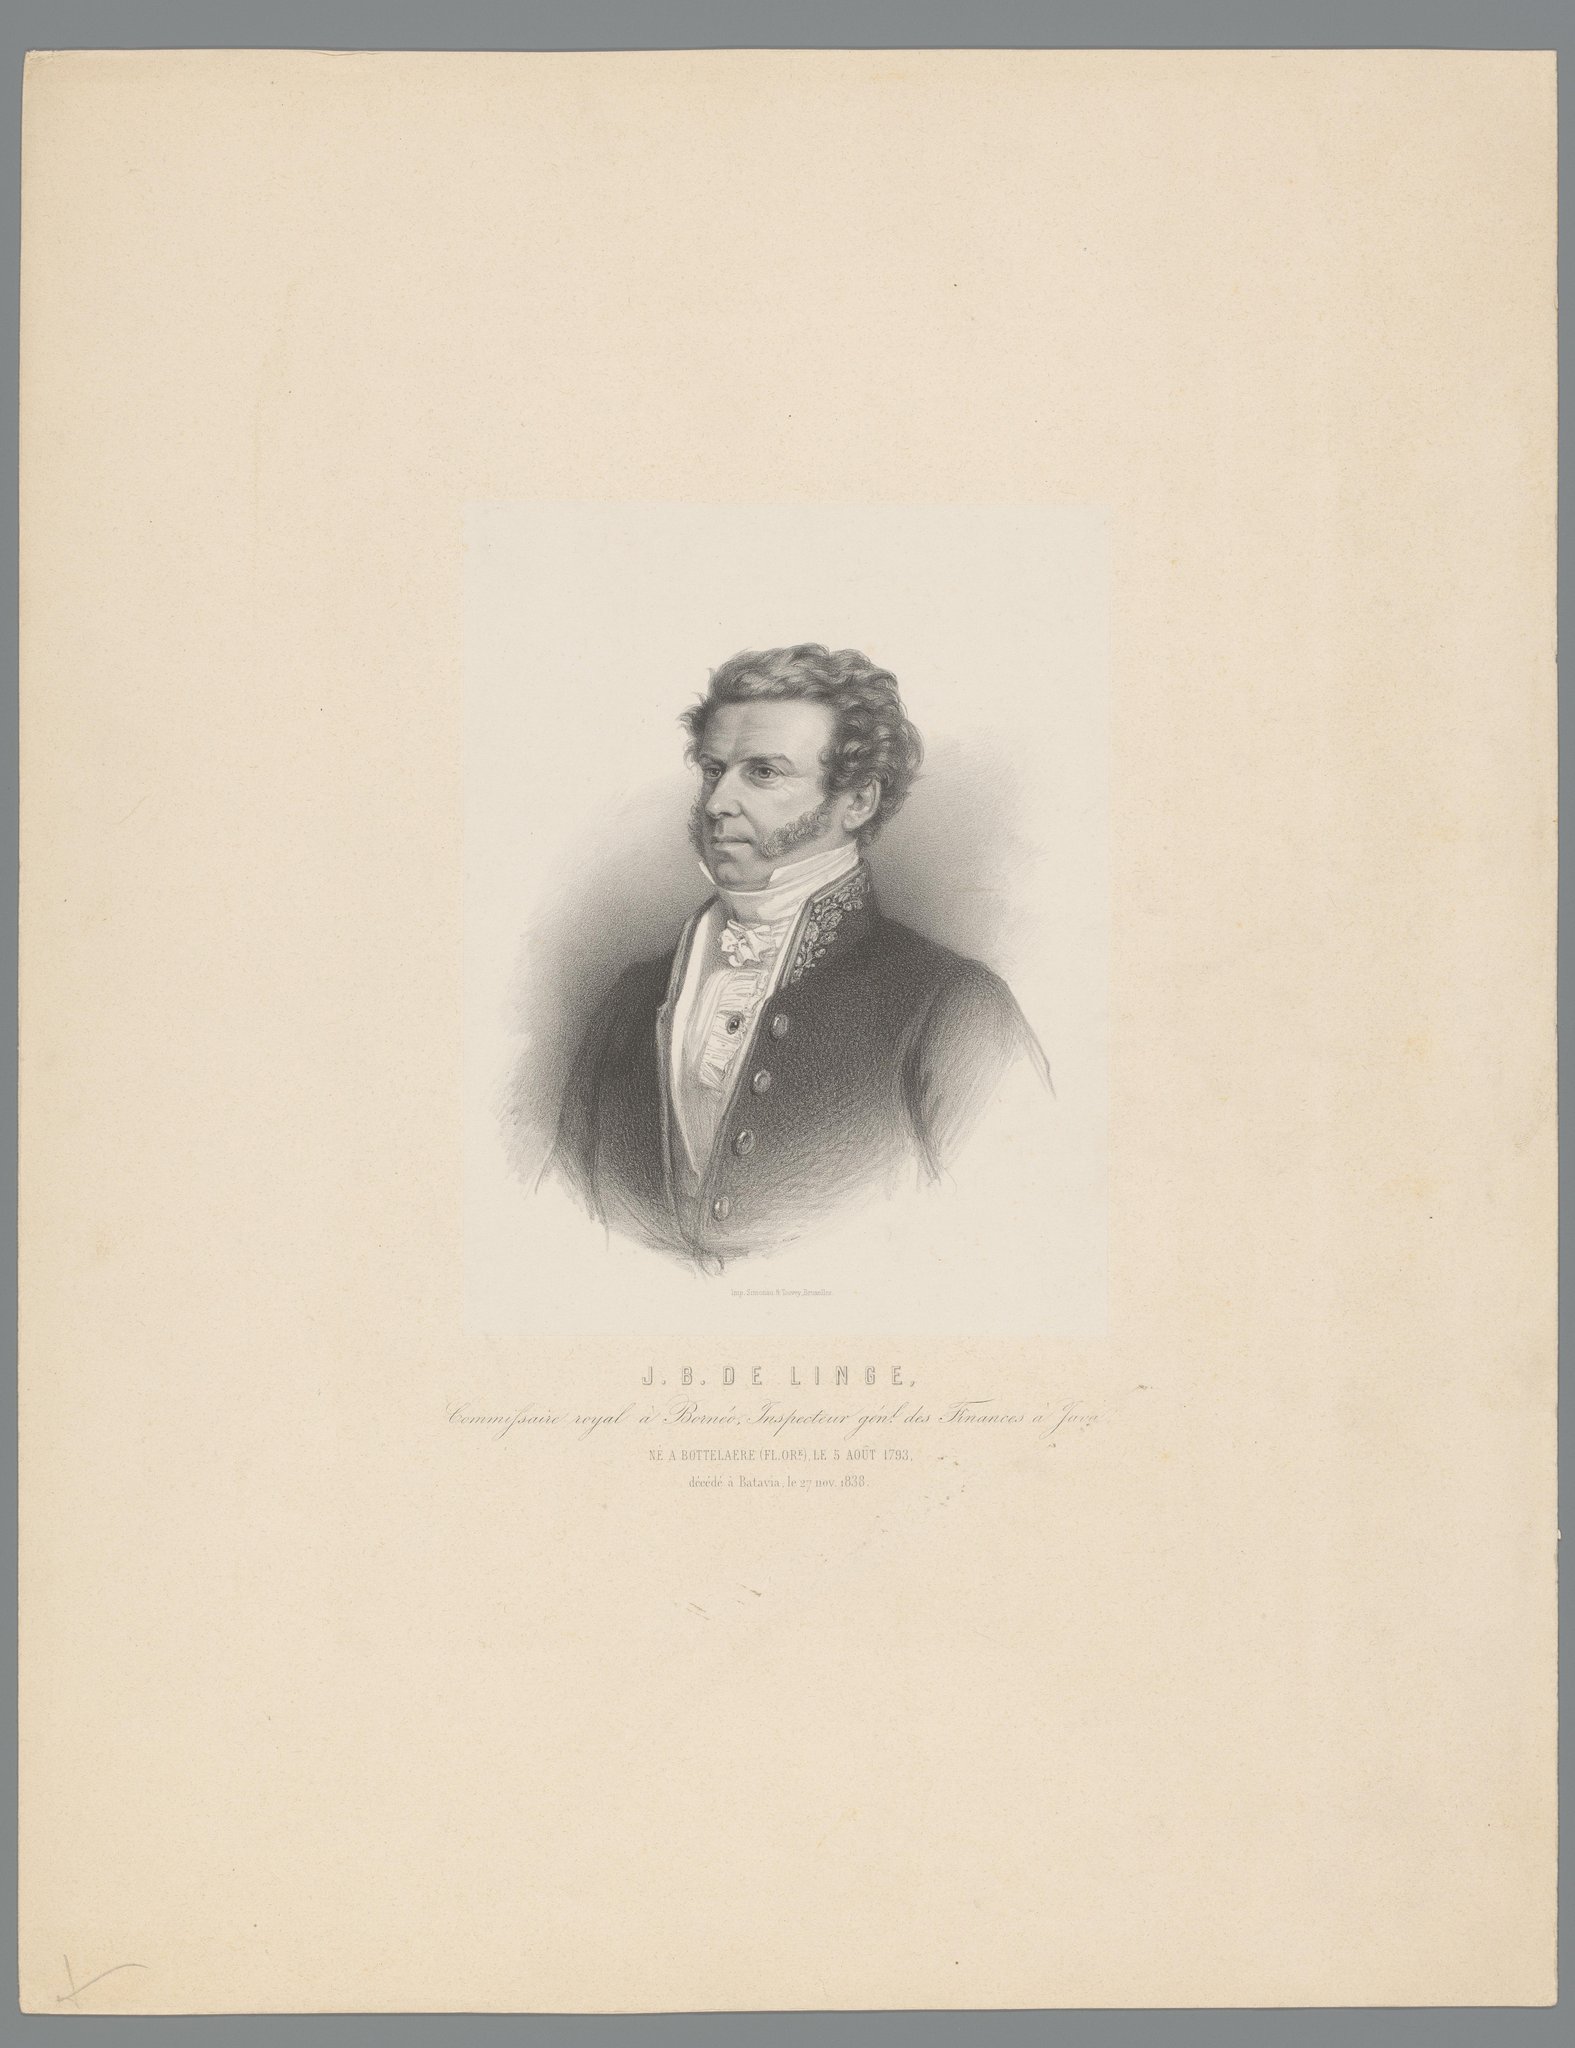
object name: print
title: Portret van J.B. de Linge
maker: joseph schubert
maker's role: print maker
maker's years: 1816-1885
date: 1847-1875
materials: paper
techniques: lithograph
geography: brussels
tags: historical persons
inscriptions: collector's mark: Lugt 2228